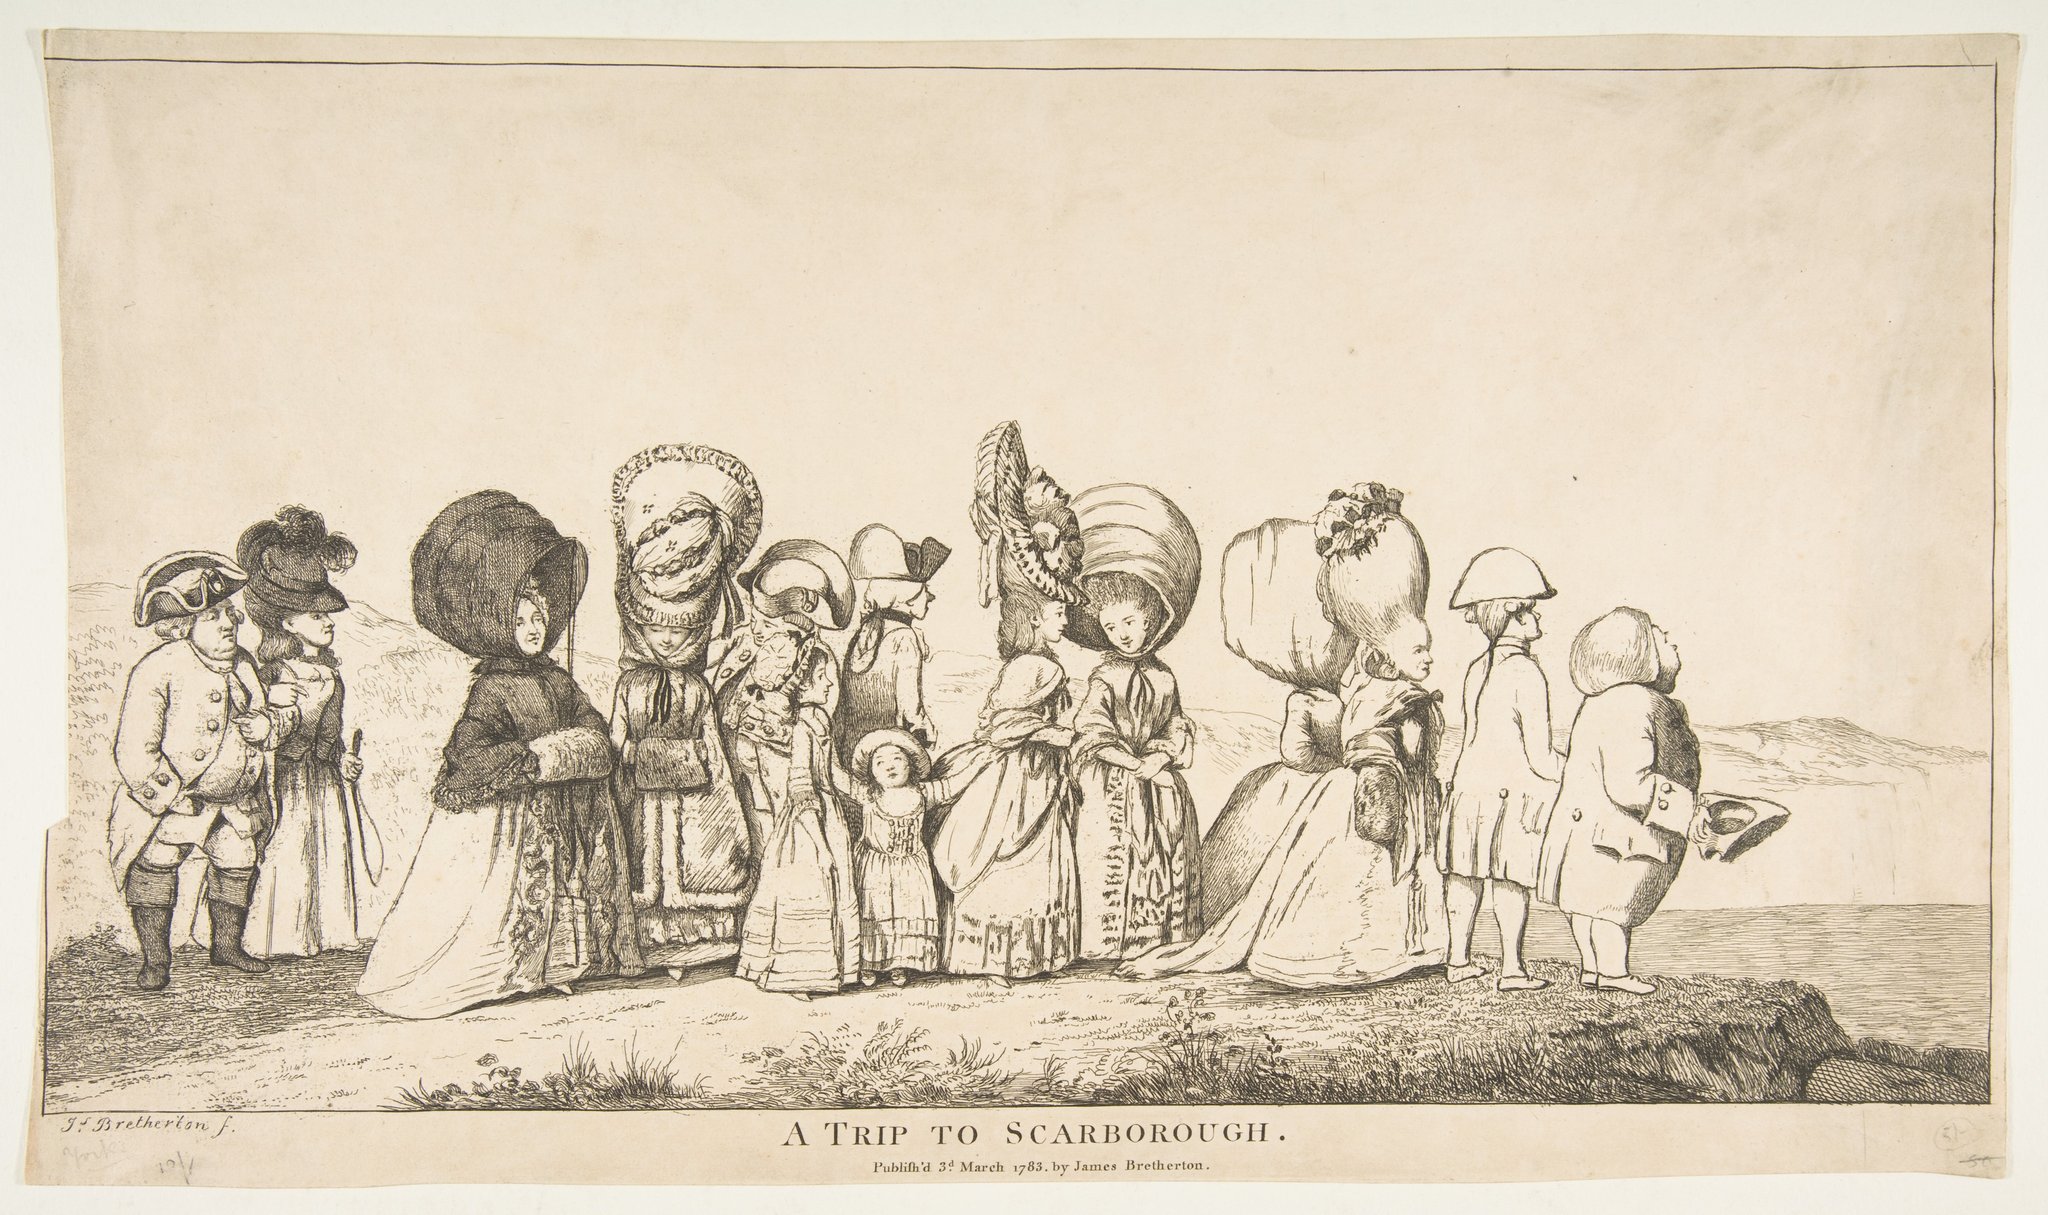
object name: print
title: A Trip to Scarborough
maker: james bretherton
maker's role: artist and publisher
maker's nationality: british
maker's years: 1750-1799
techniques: etching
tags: girls,men,women